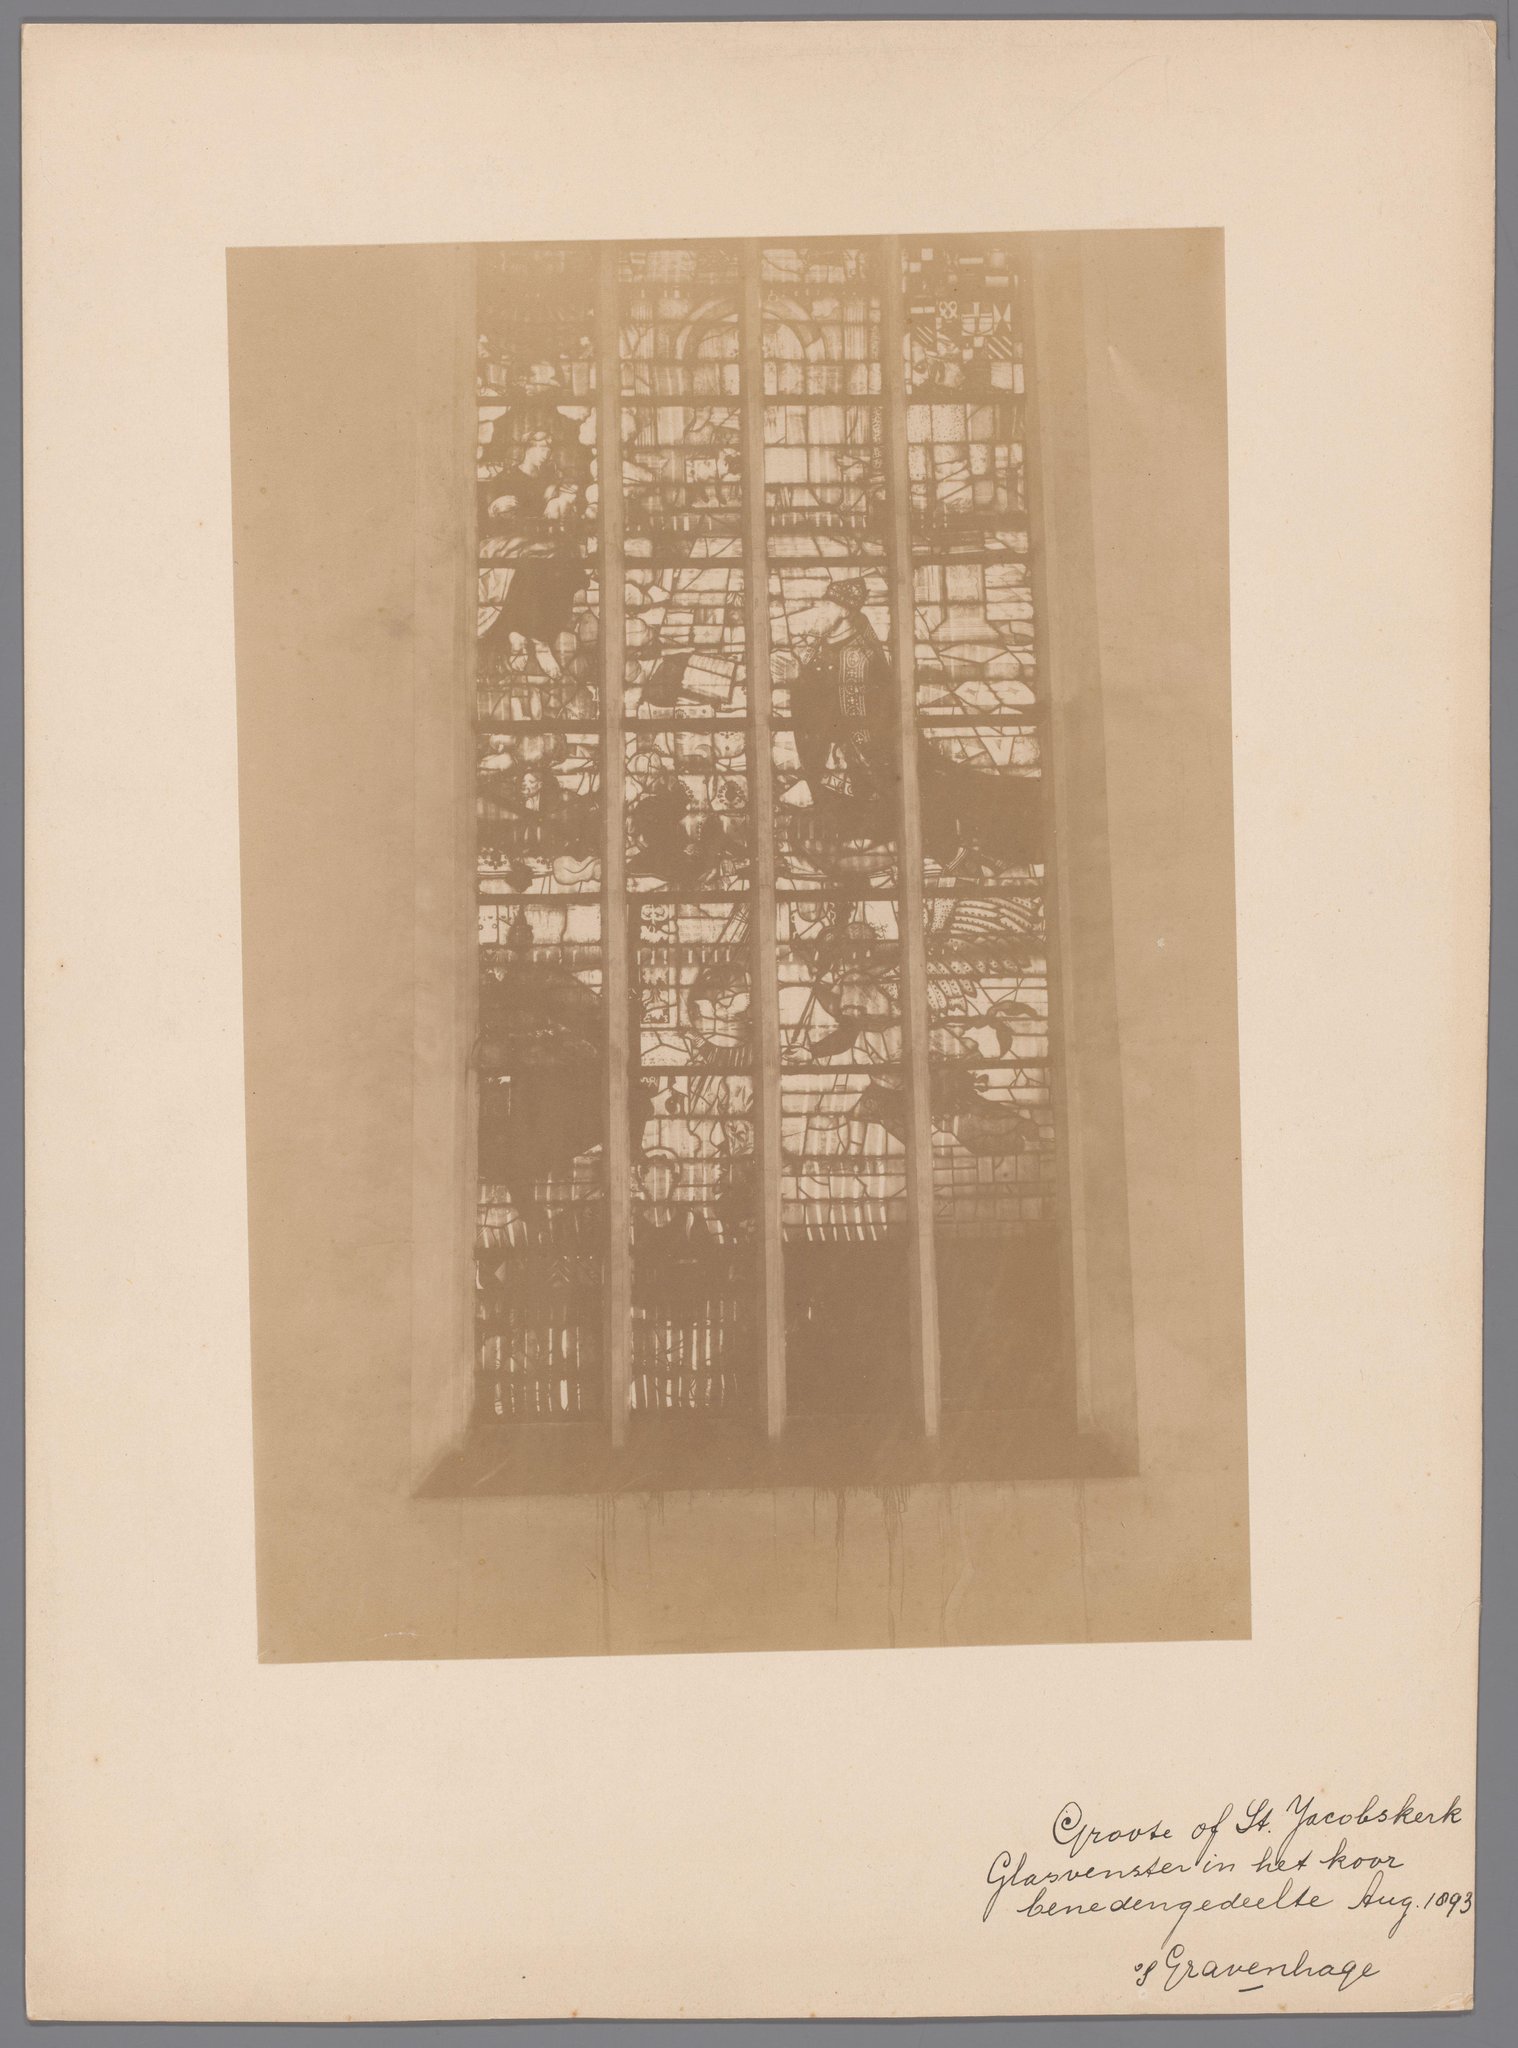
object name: photograph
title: Geschilderd raam in de Grote of Sint-Jacobskerk te Den Haag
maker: anoniem (monumentenzorg)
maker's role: fotograaf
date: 1893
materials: cardboard, photographic support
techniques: albumen print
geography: grote kerk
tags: church-window, e.g. rose-window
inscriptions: collector's mark: ‘R:MUS.’ Lugt 2228, annotation: ‘S. Jacobskerk te 's Gravenhage (Z.H.)/ Glasvenster in het koor (benedengedeelte)/ Aug 1893’, annotation: ‘Groote of St. Jacobskerk/ glasvenster in het koor benedengedeelte Aug. 1893/ 's Gravenhage’